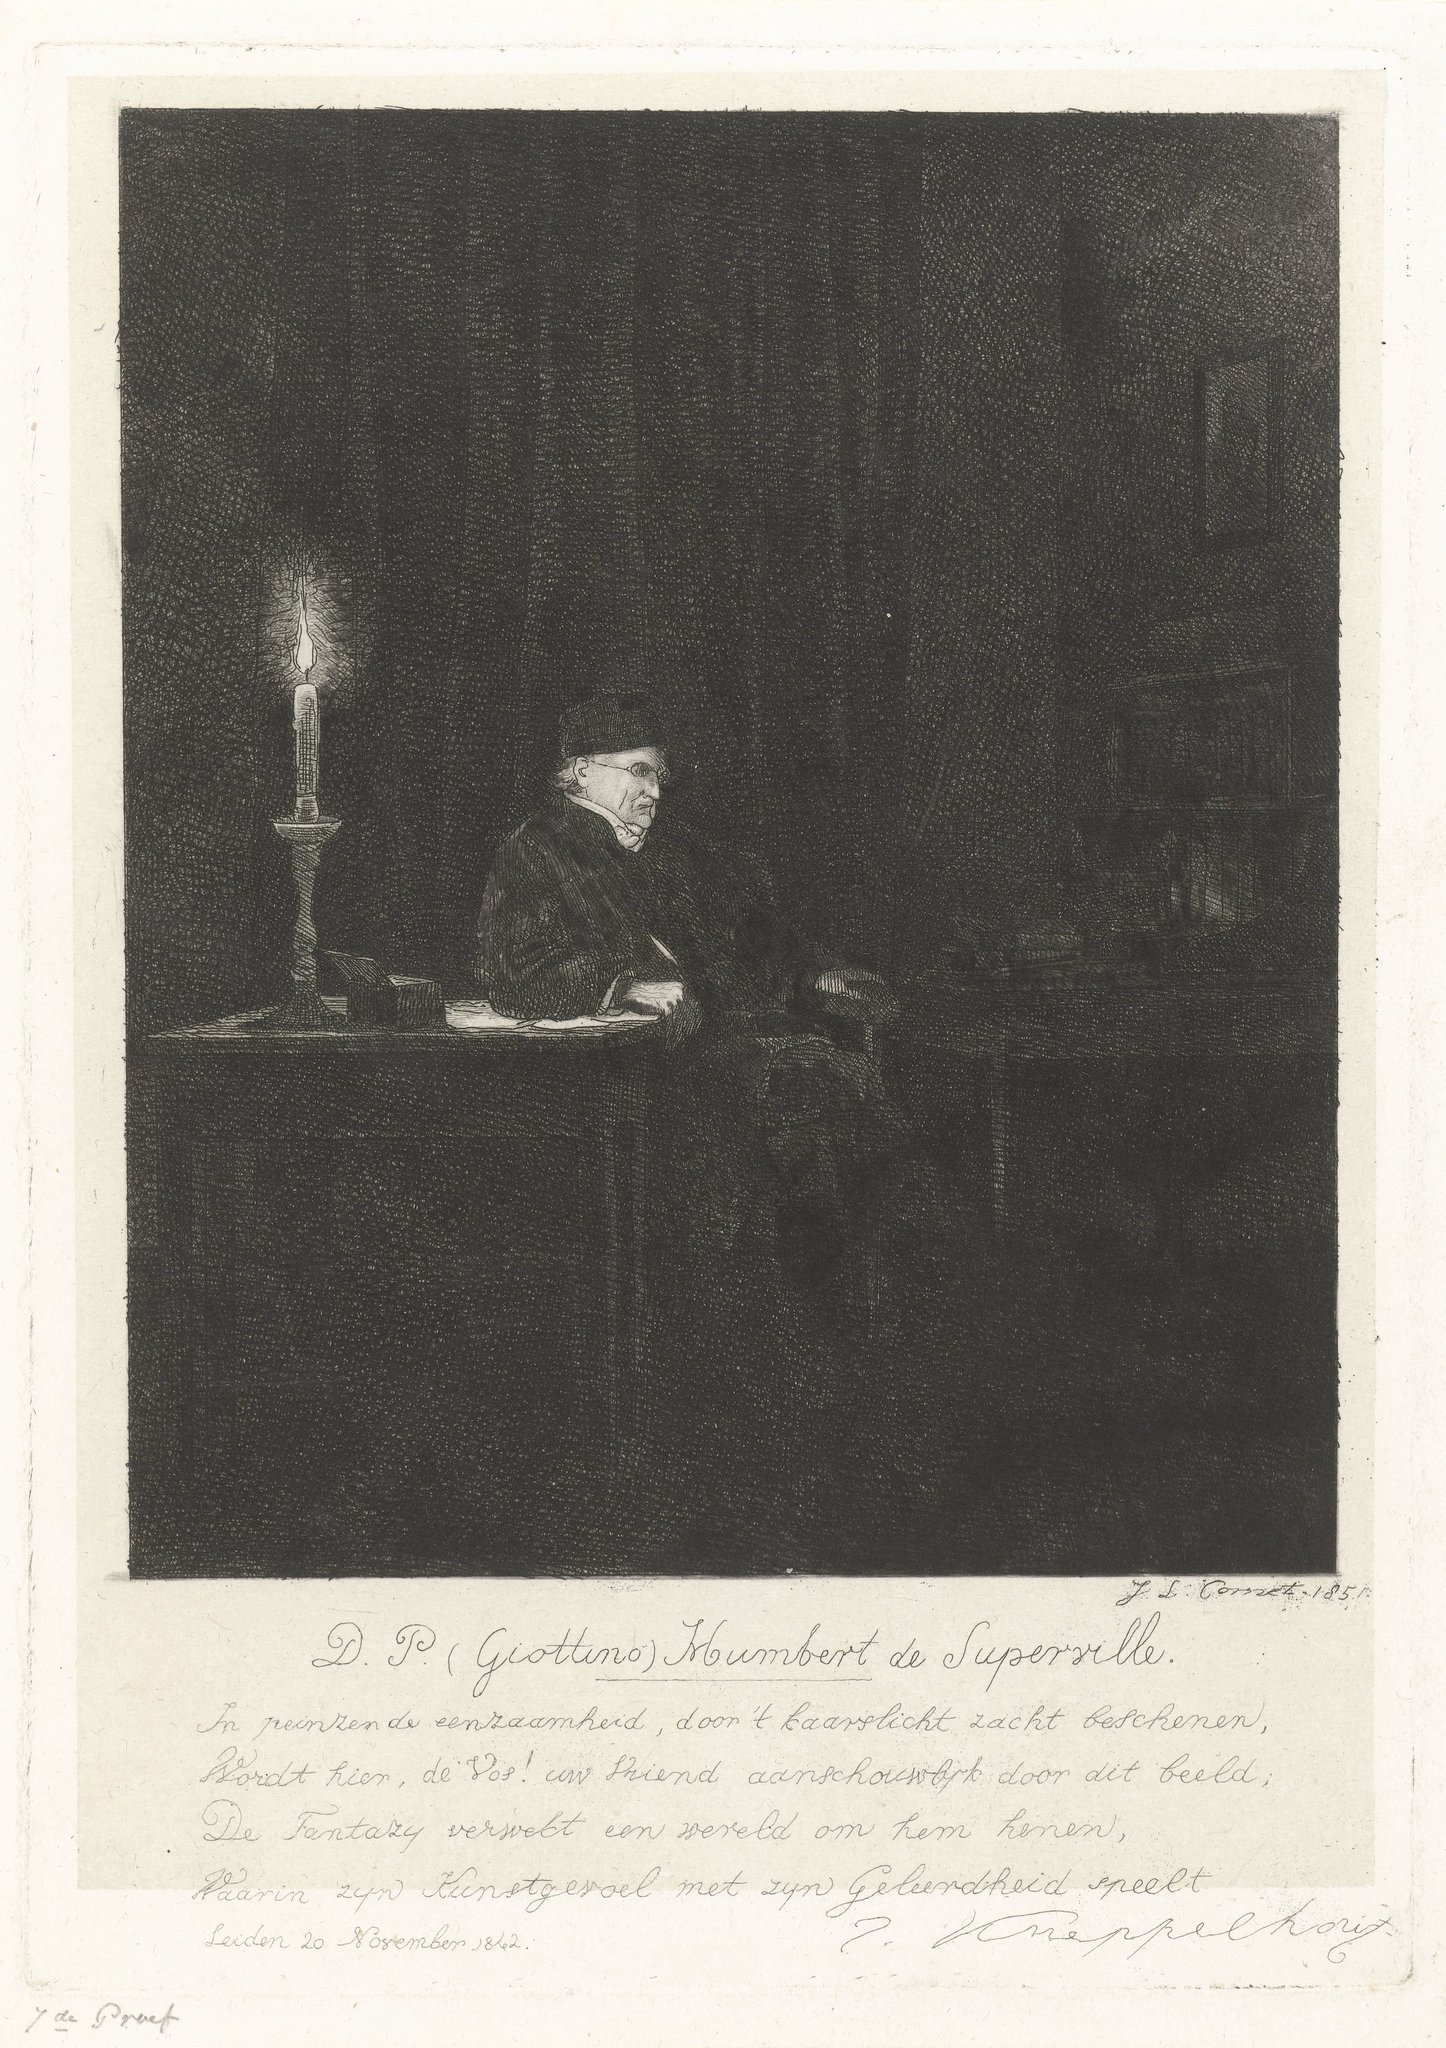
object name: print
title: Portret van Humbert de Superville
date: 1851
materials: paper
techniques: etching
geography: leiden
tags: the hague, leiden, painter, print maker, draughtsman, david pièrre giottino humbert de superville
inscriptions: caption: ‘7ste proef’, collector's mark: Lugt 2228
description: Portret van David Pierre Giottino Humbert de Superville, een kunstenaar en kunstverzamelaar. Humbert de Superville zit aan zijn bureau . De kamer wordt slechts verlicht door een kaars. De prent heeft een Nederlands onderschrift in vier verzen.